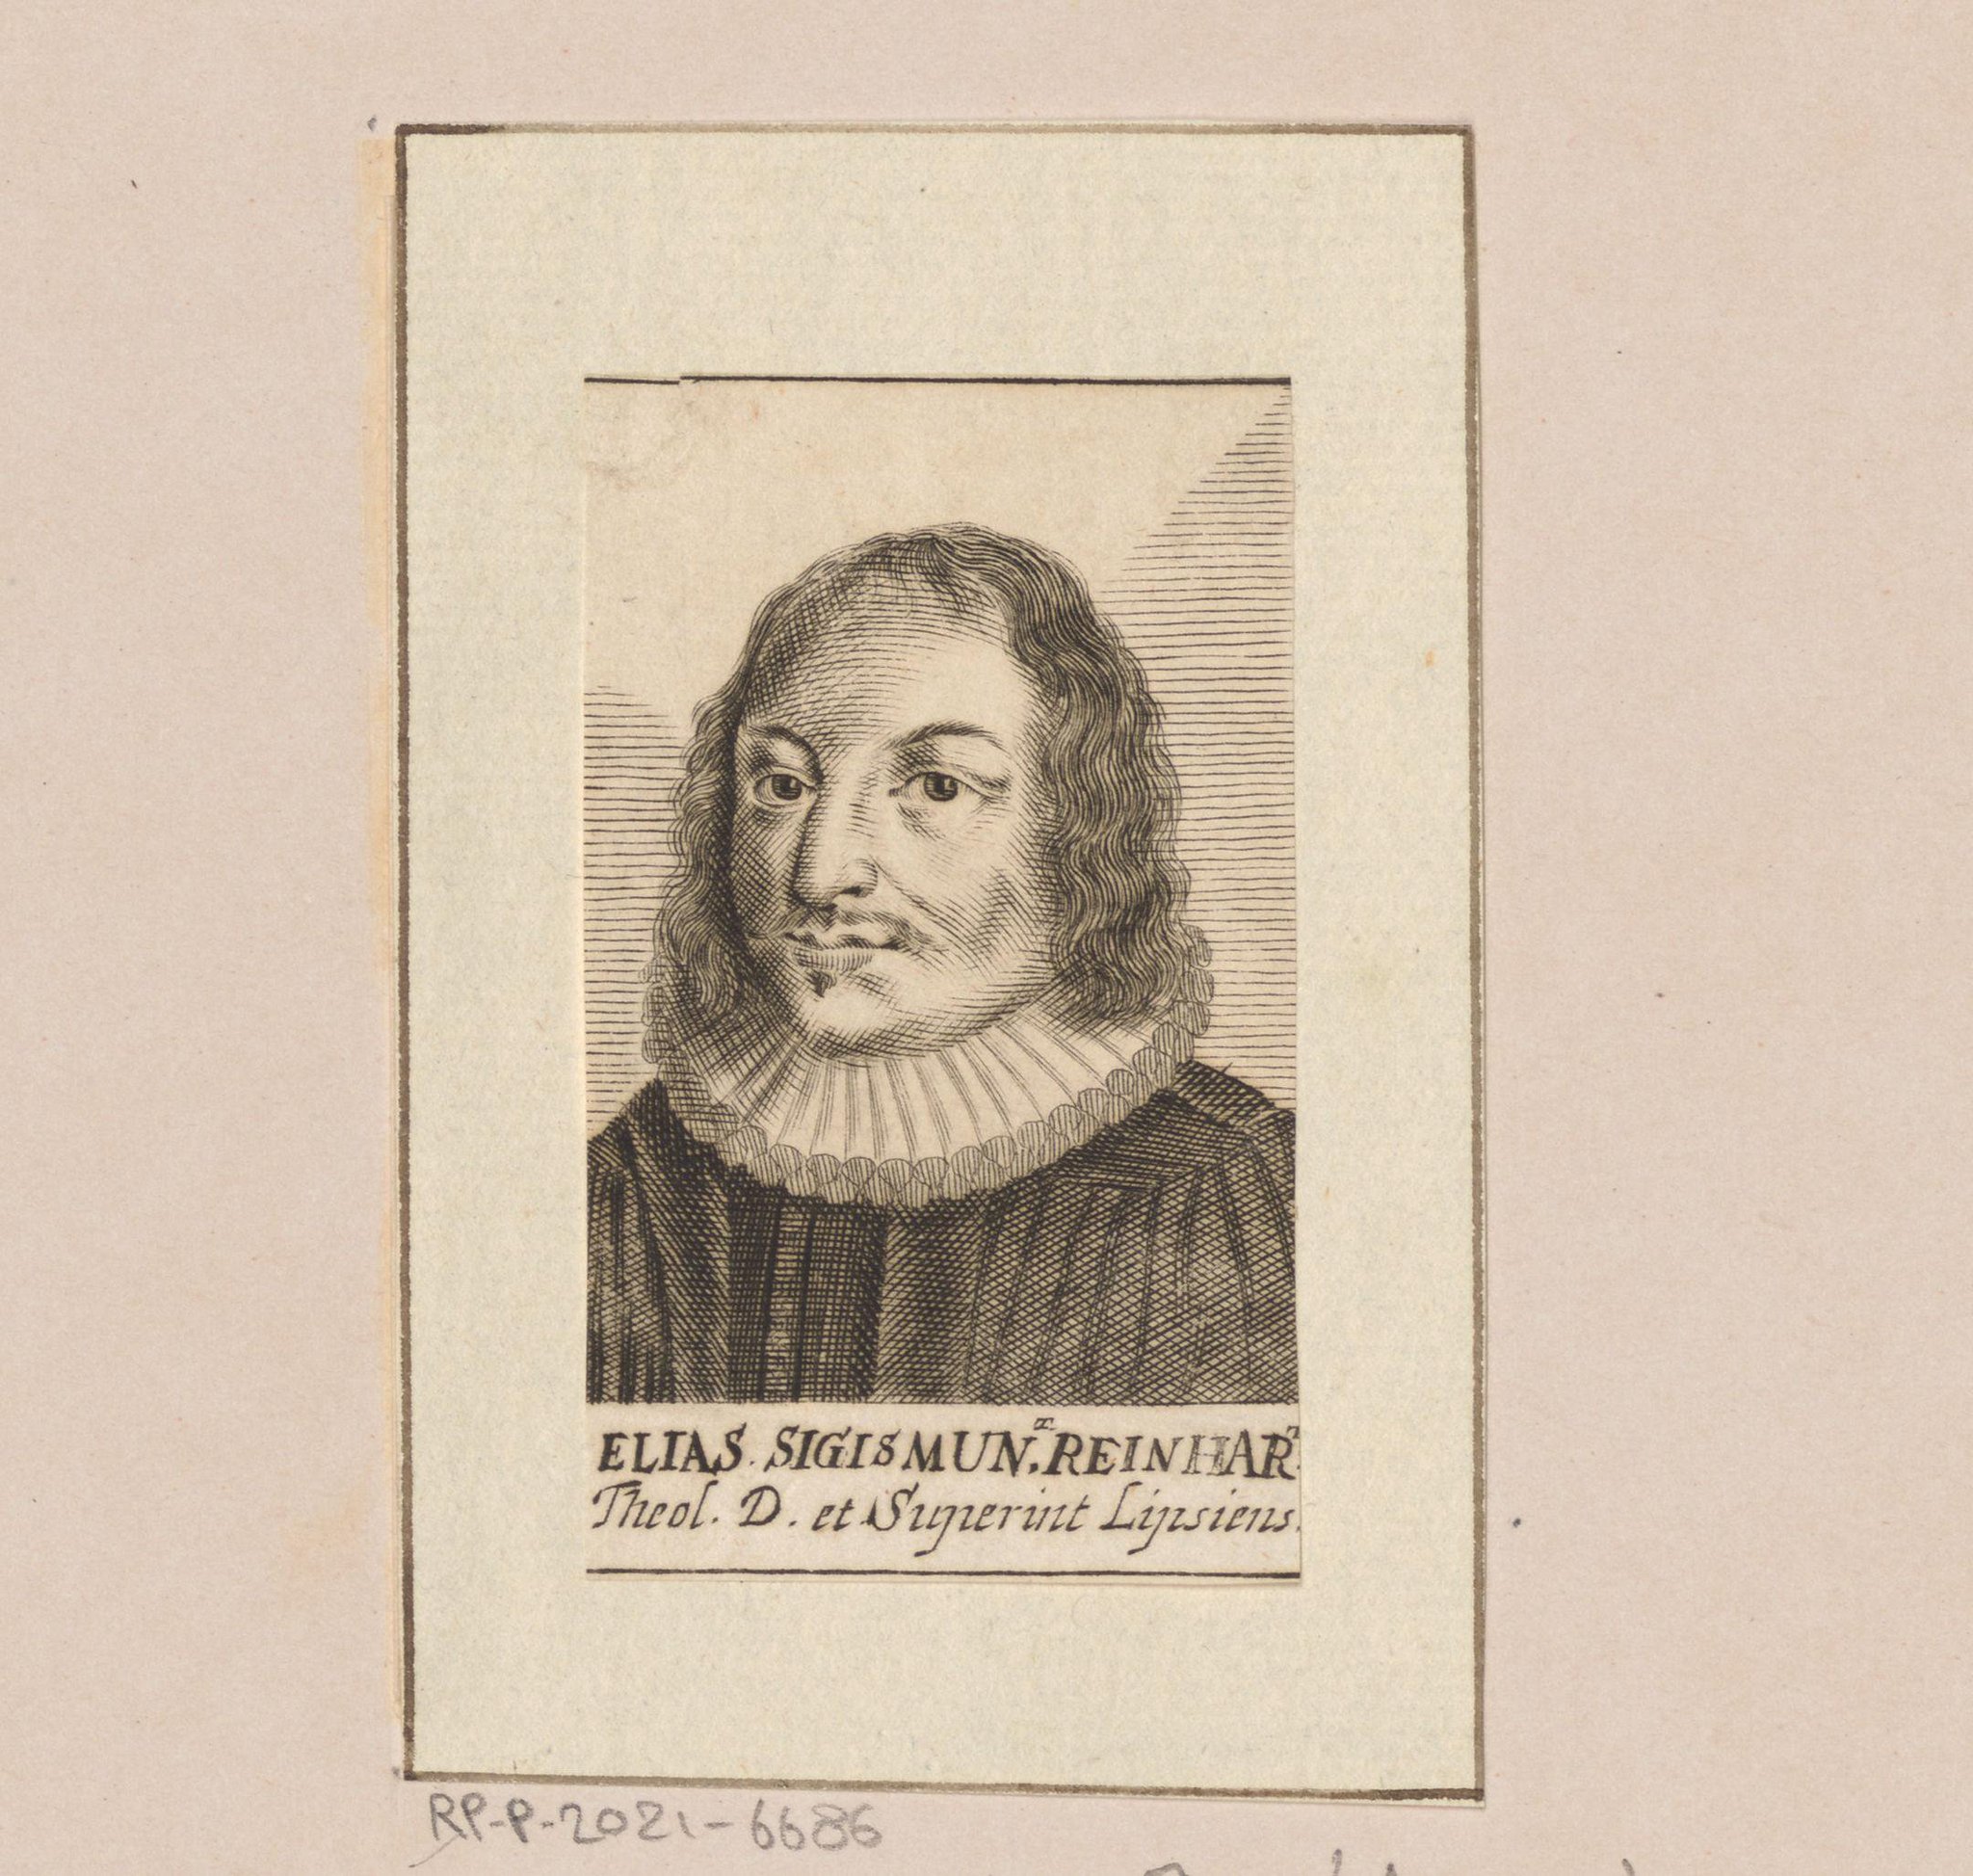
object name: print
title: Portret van Elias Sigismund Reinhard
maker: johann franck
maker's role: print maker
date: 1688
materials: paper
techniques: engraving, etching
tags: historical persons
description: Prent mogelijk uit: Freher, Paul. Theatrum virorum eruditione clarorum. Neurenberg: Johann Hoffmann, 1688.